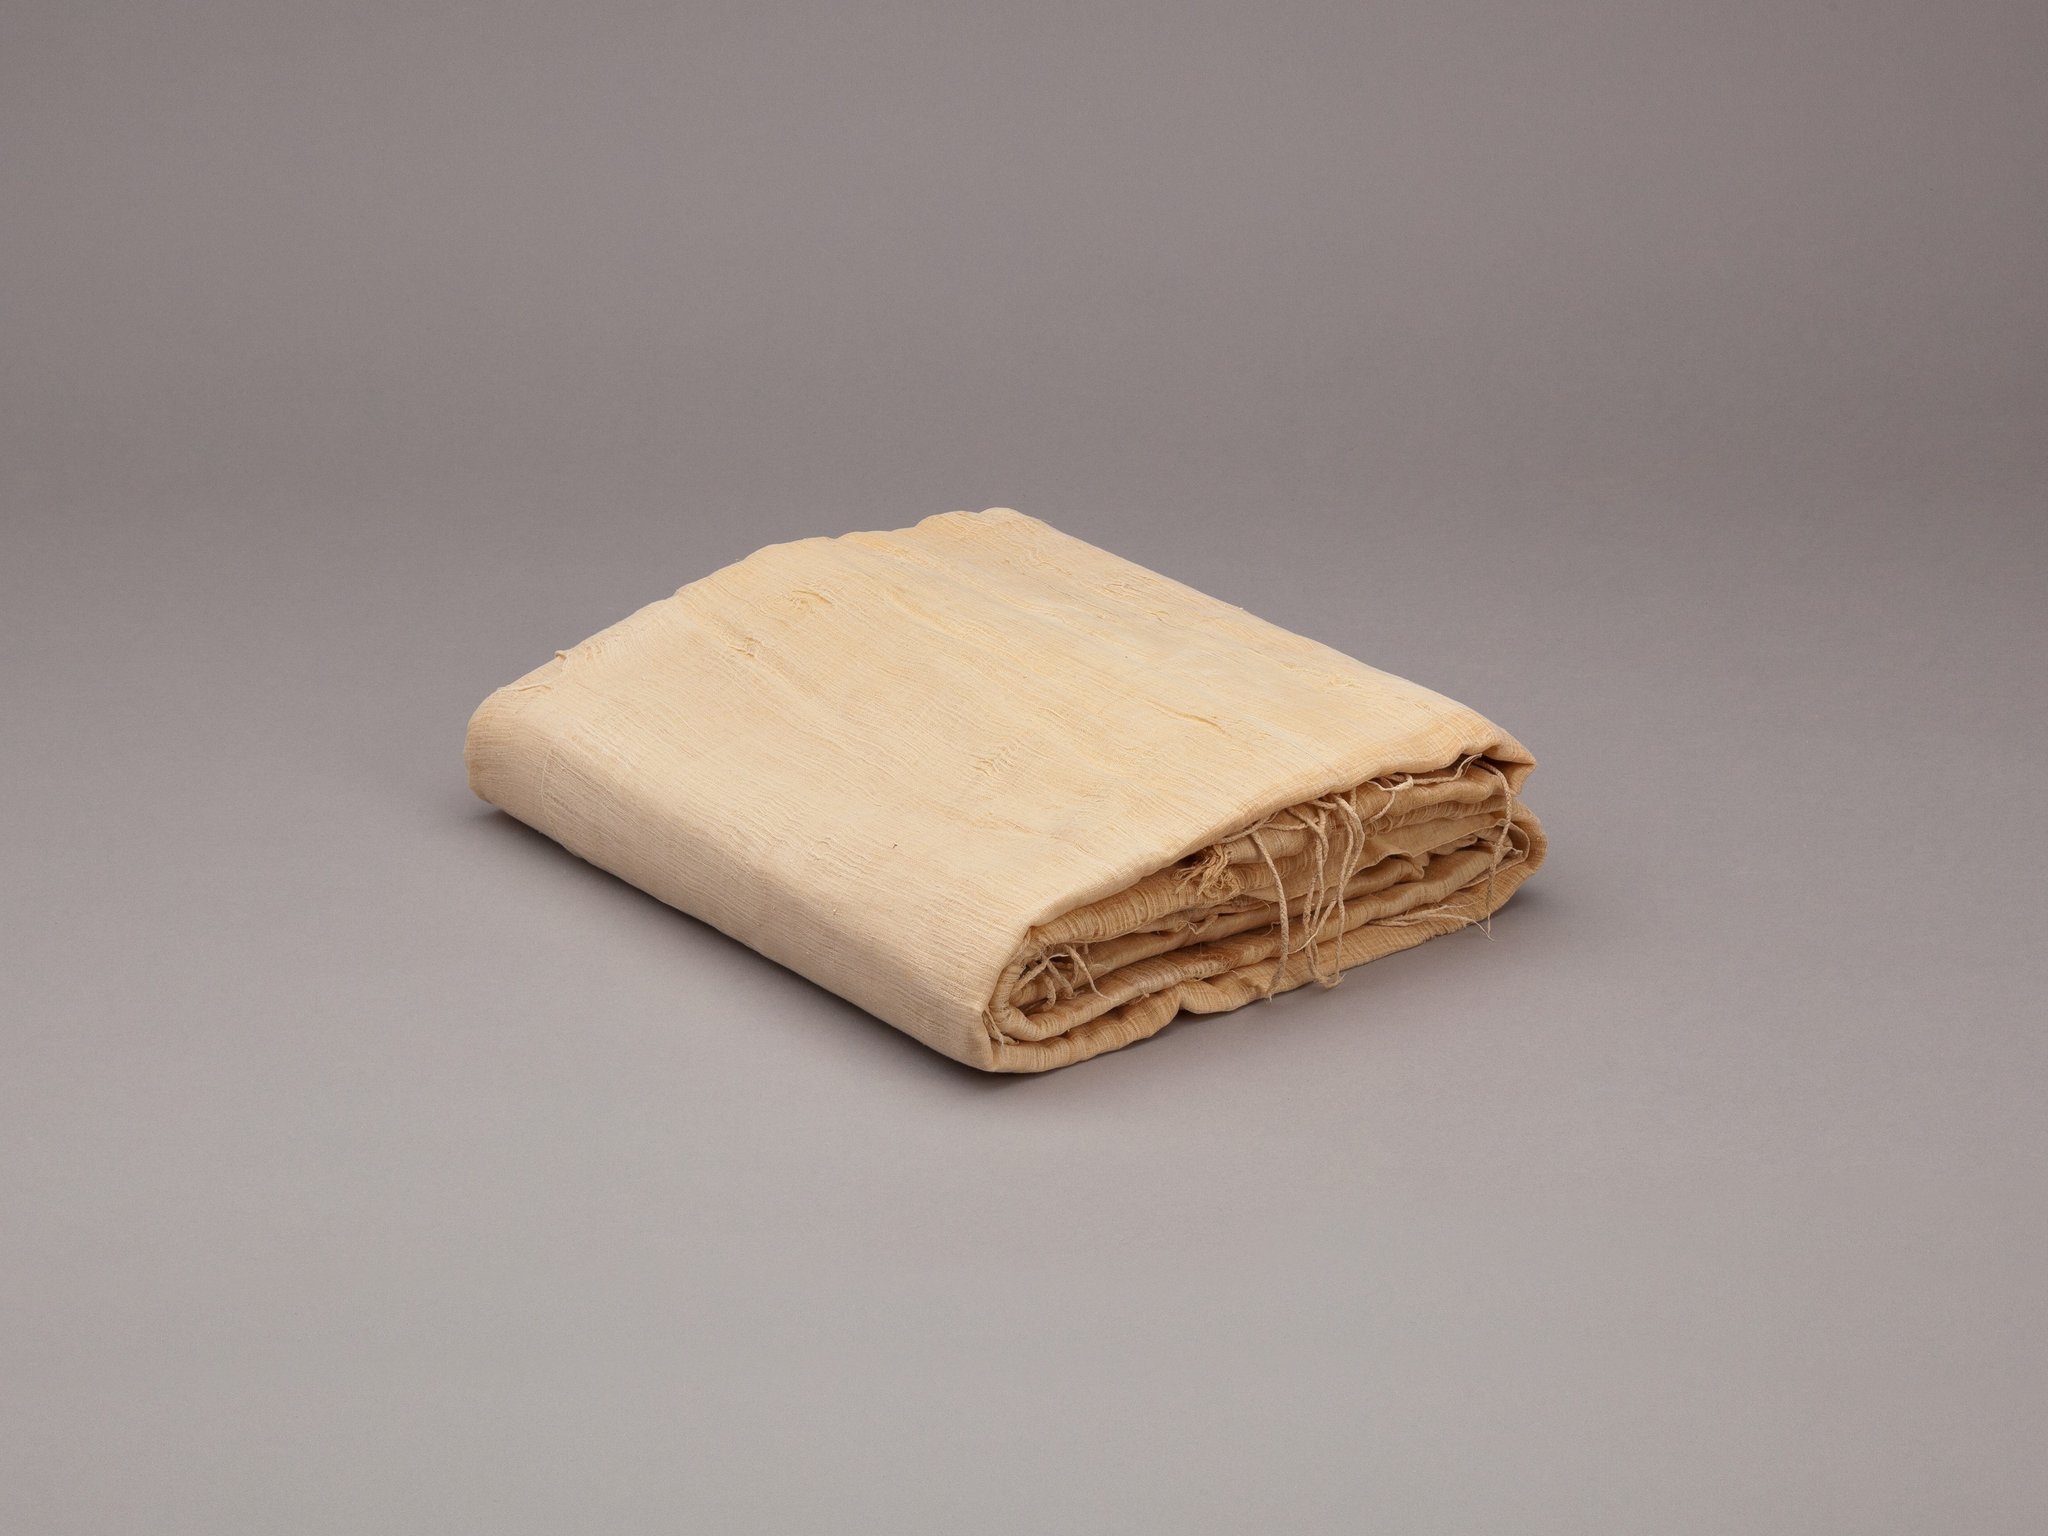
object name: linen mark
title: Sheet, linen mark, fine spin, irregular weave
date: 1492-1473 BCE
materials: linen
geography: egypt